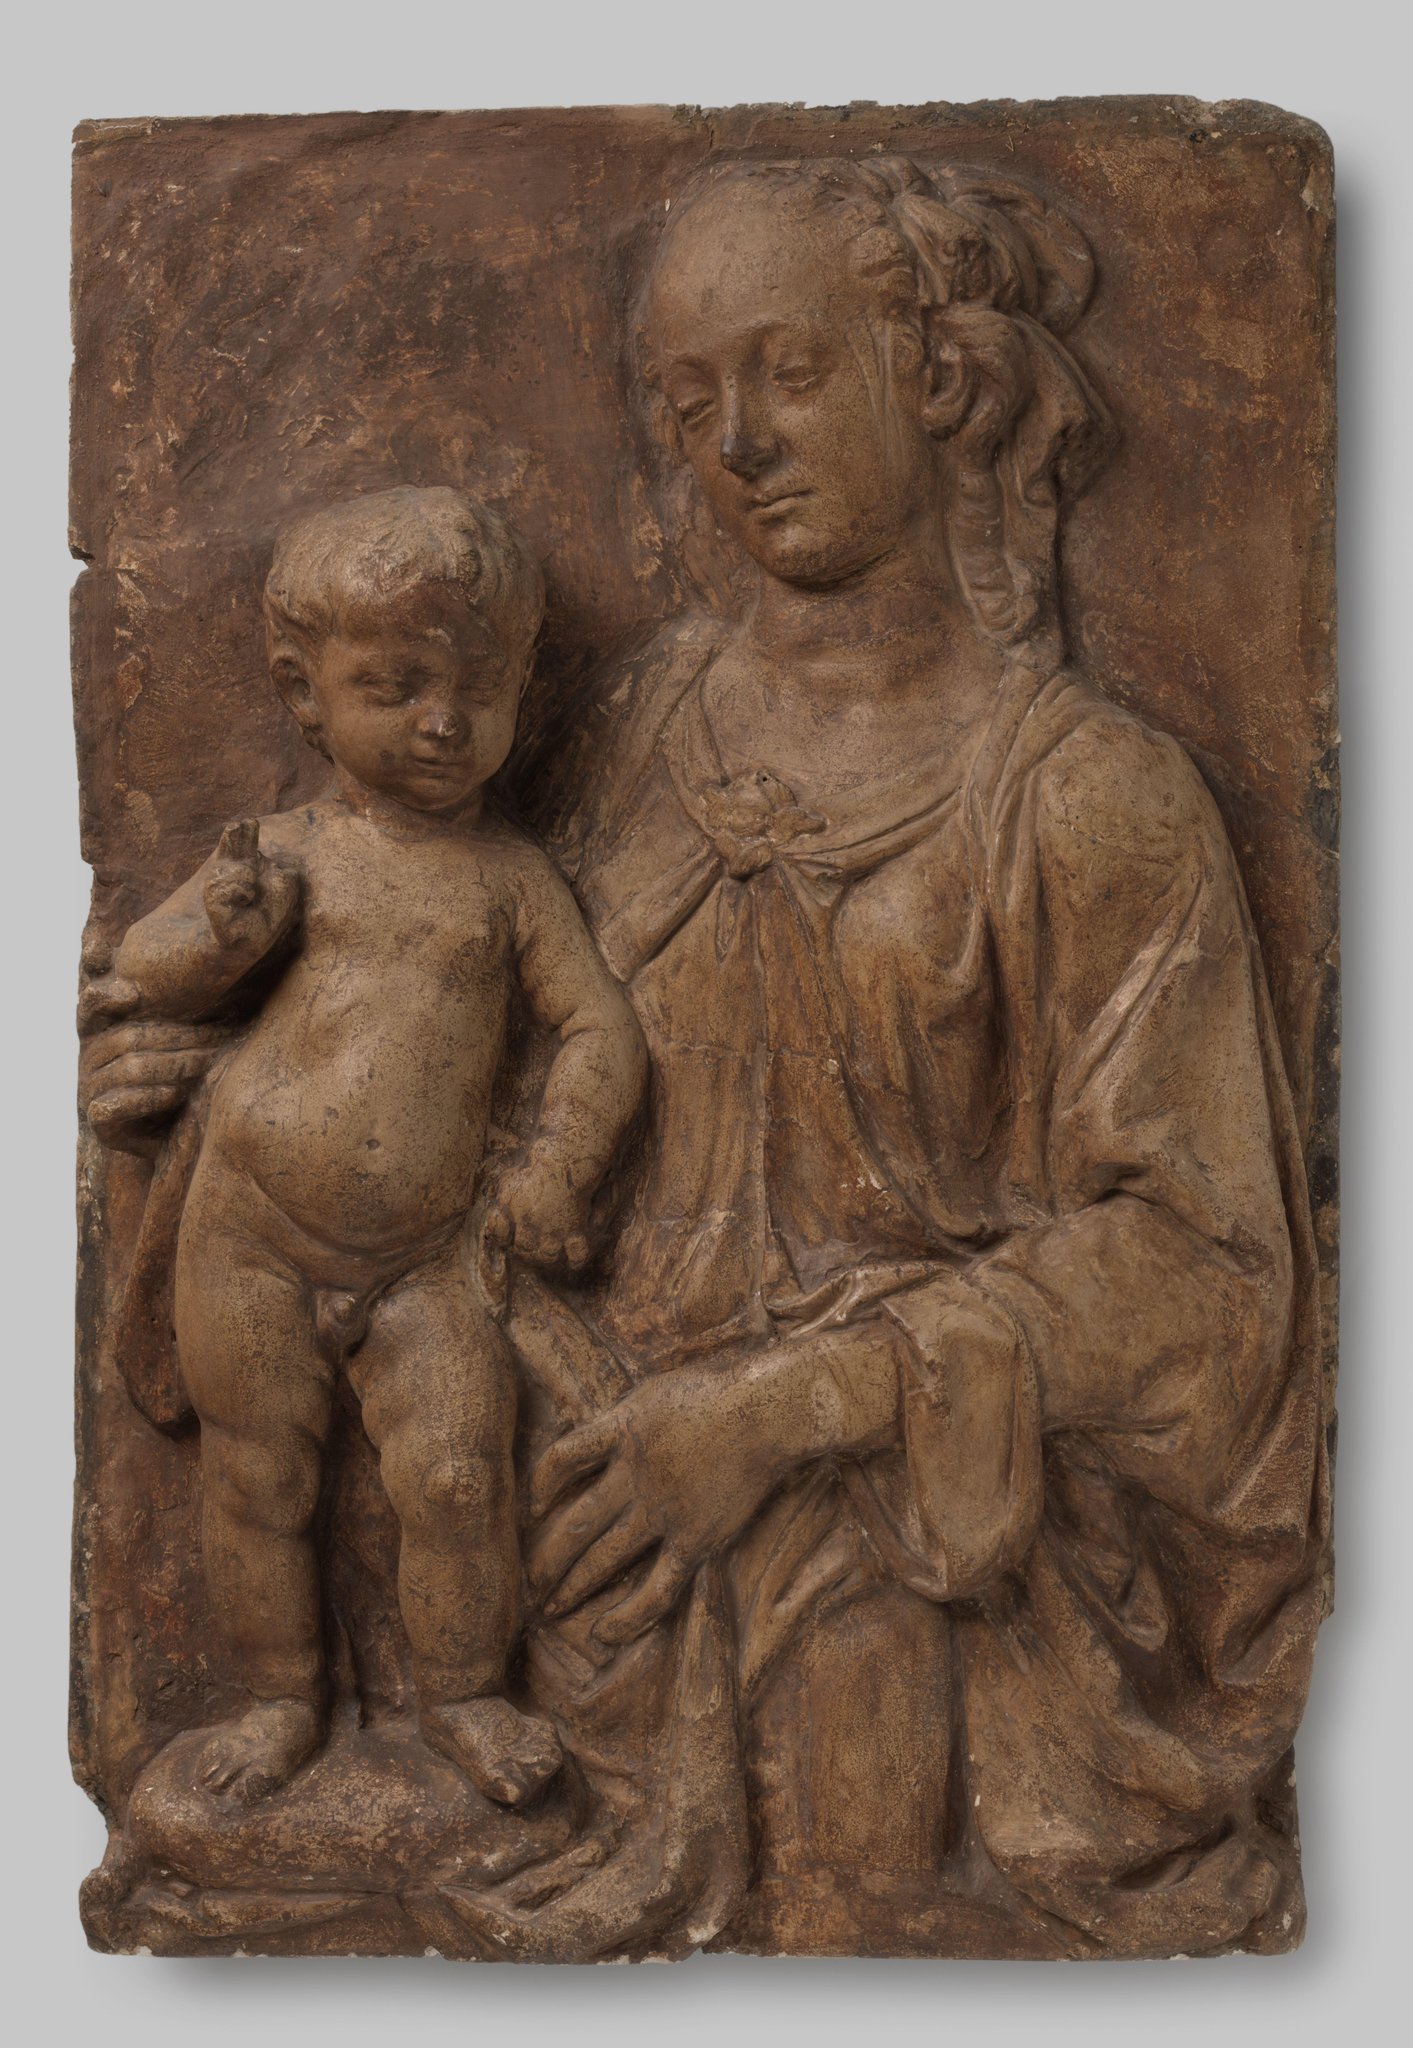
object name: sculpture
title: Maria met kind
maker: andrea del verrocchio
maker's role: jeweler, painter, sculptor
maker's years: 1435-1488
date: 1480-1490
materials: plaster